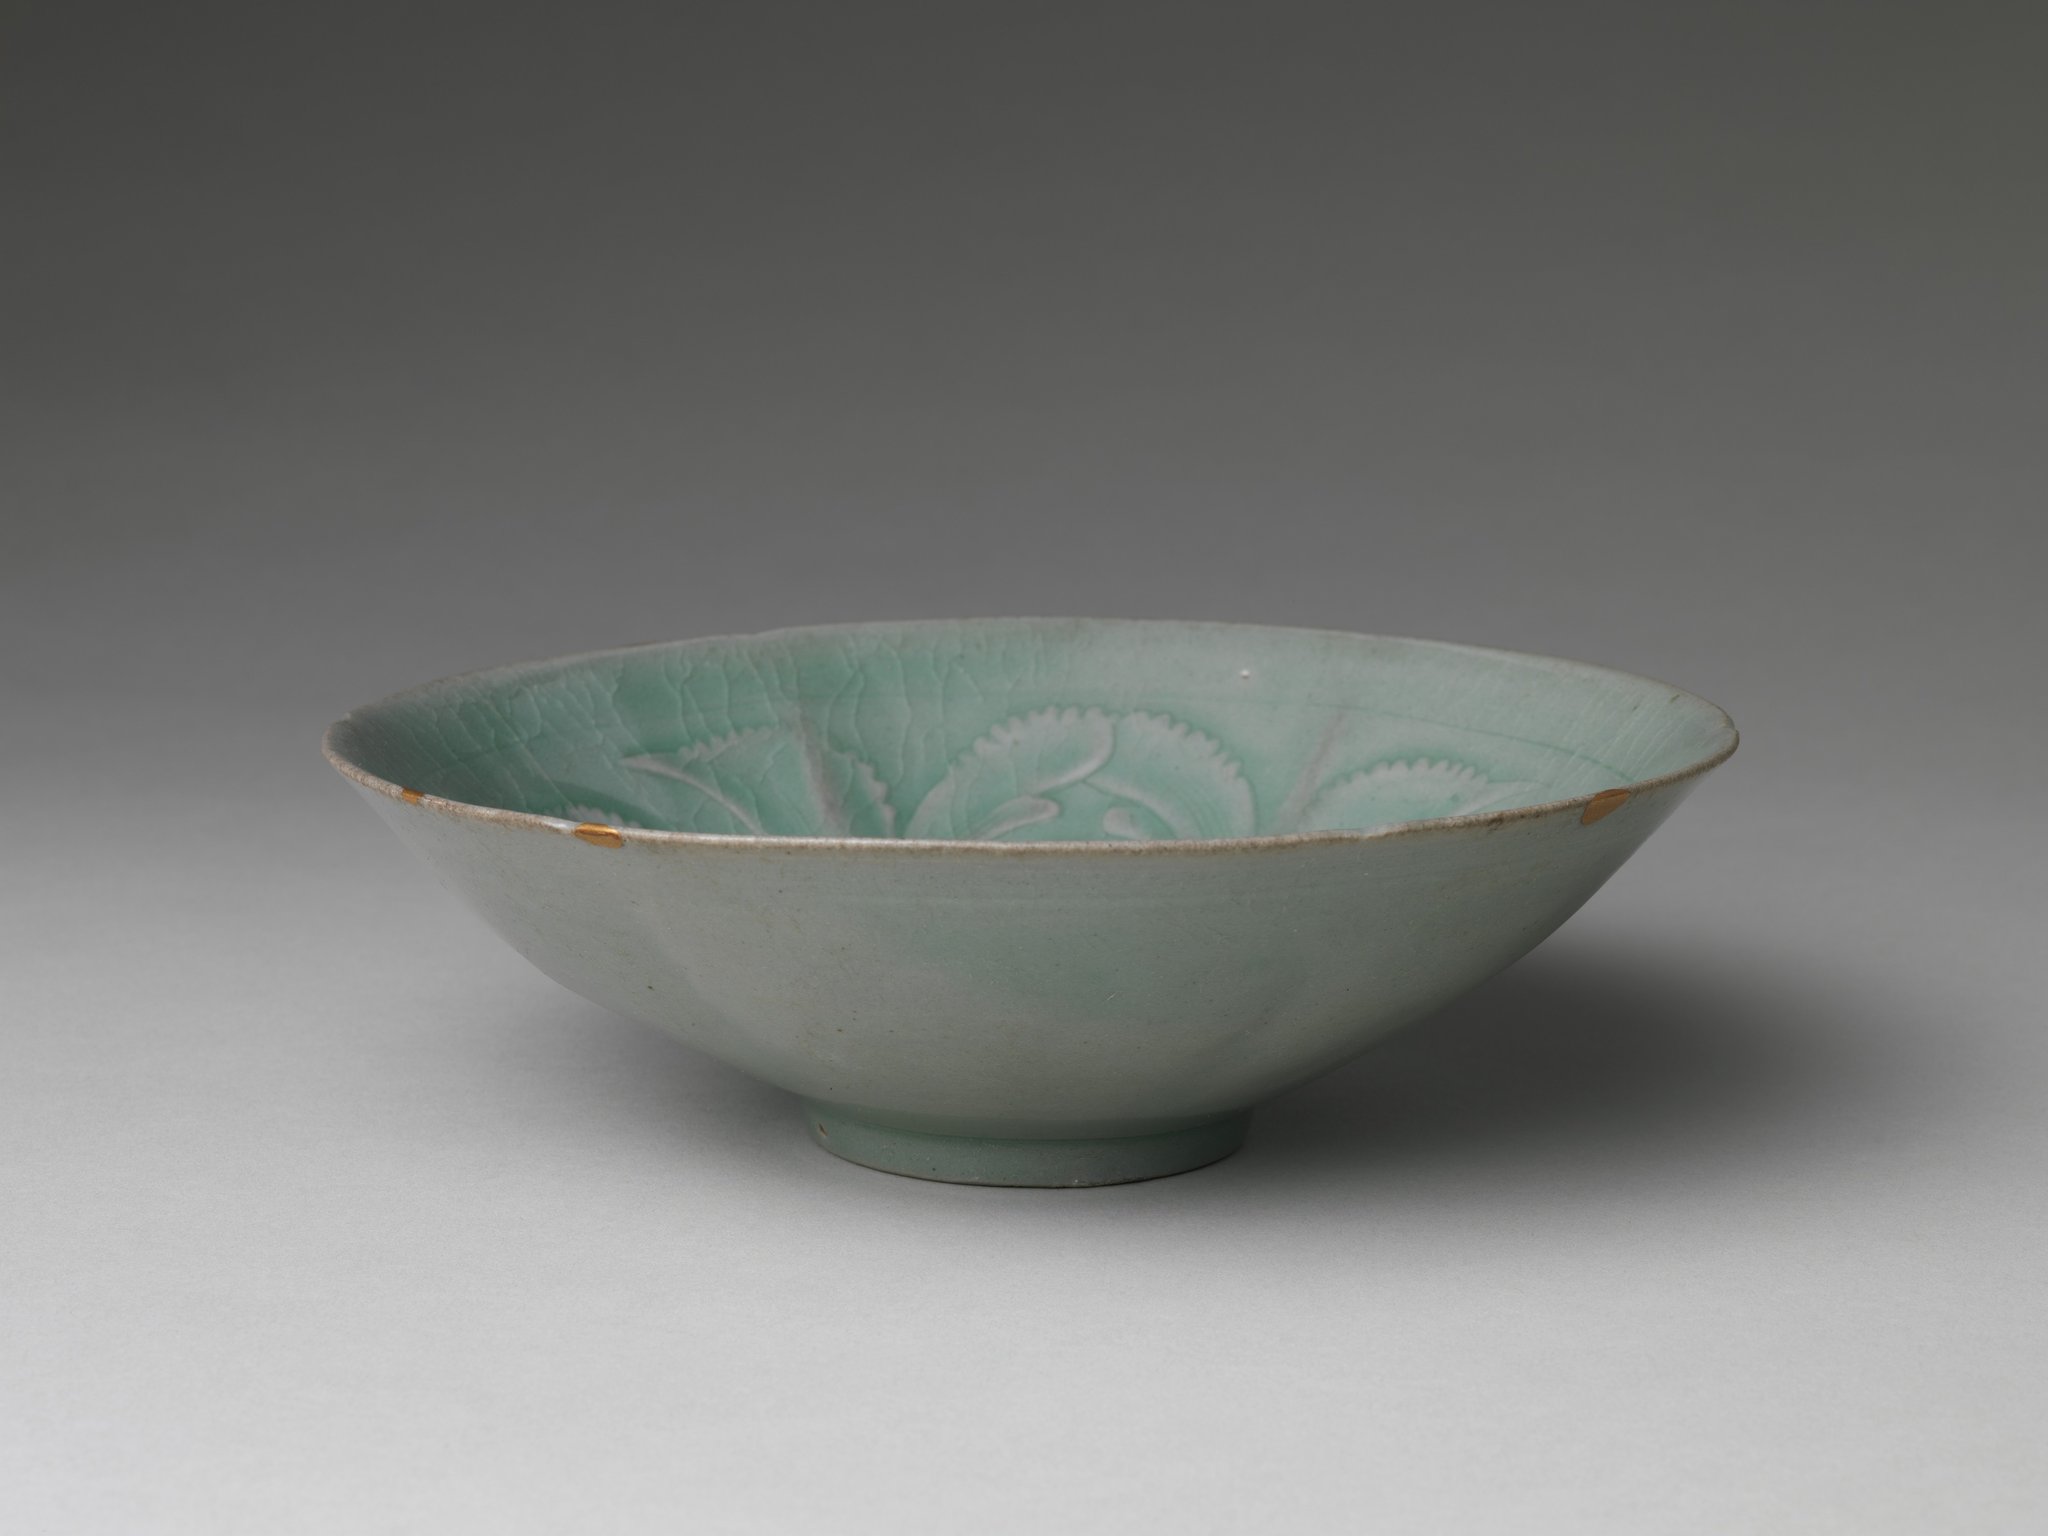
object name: bowl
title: Bowl decorated with foliate rim and peony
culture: korean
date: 1101-1133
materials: ceramic glaze, glaze, stoneware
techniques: incising